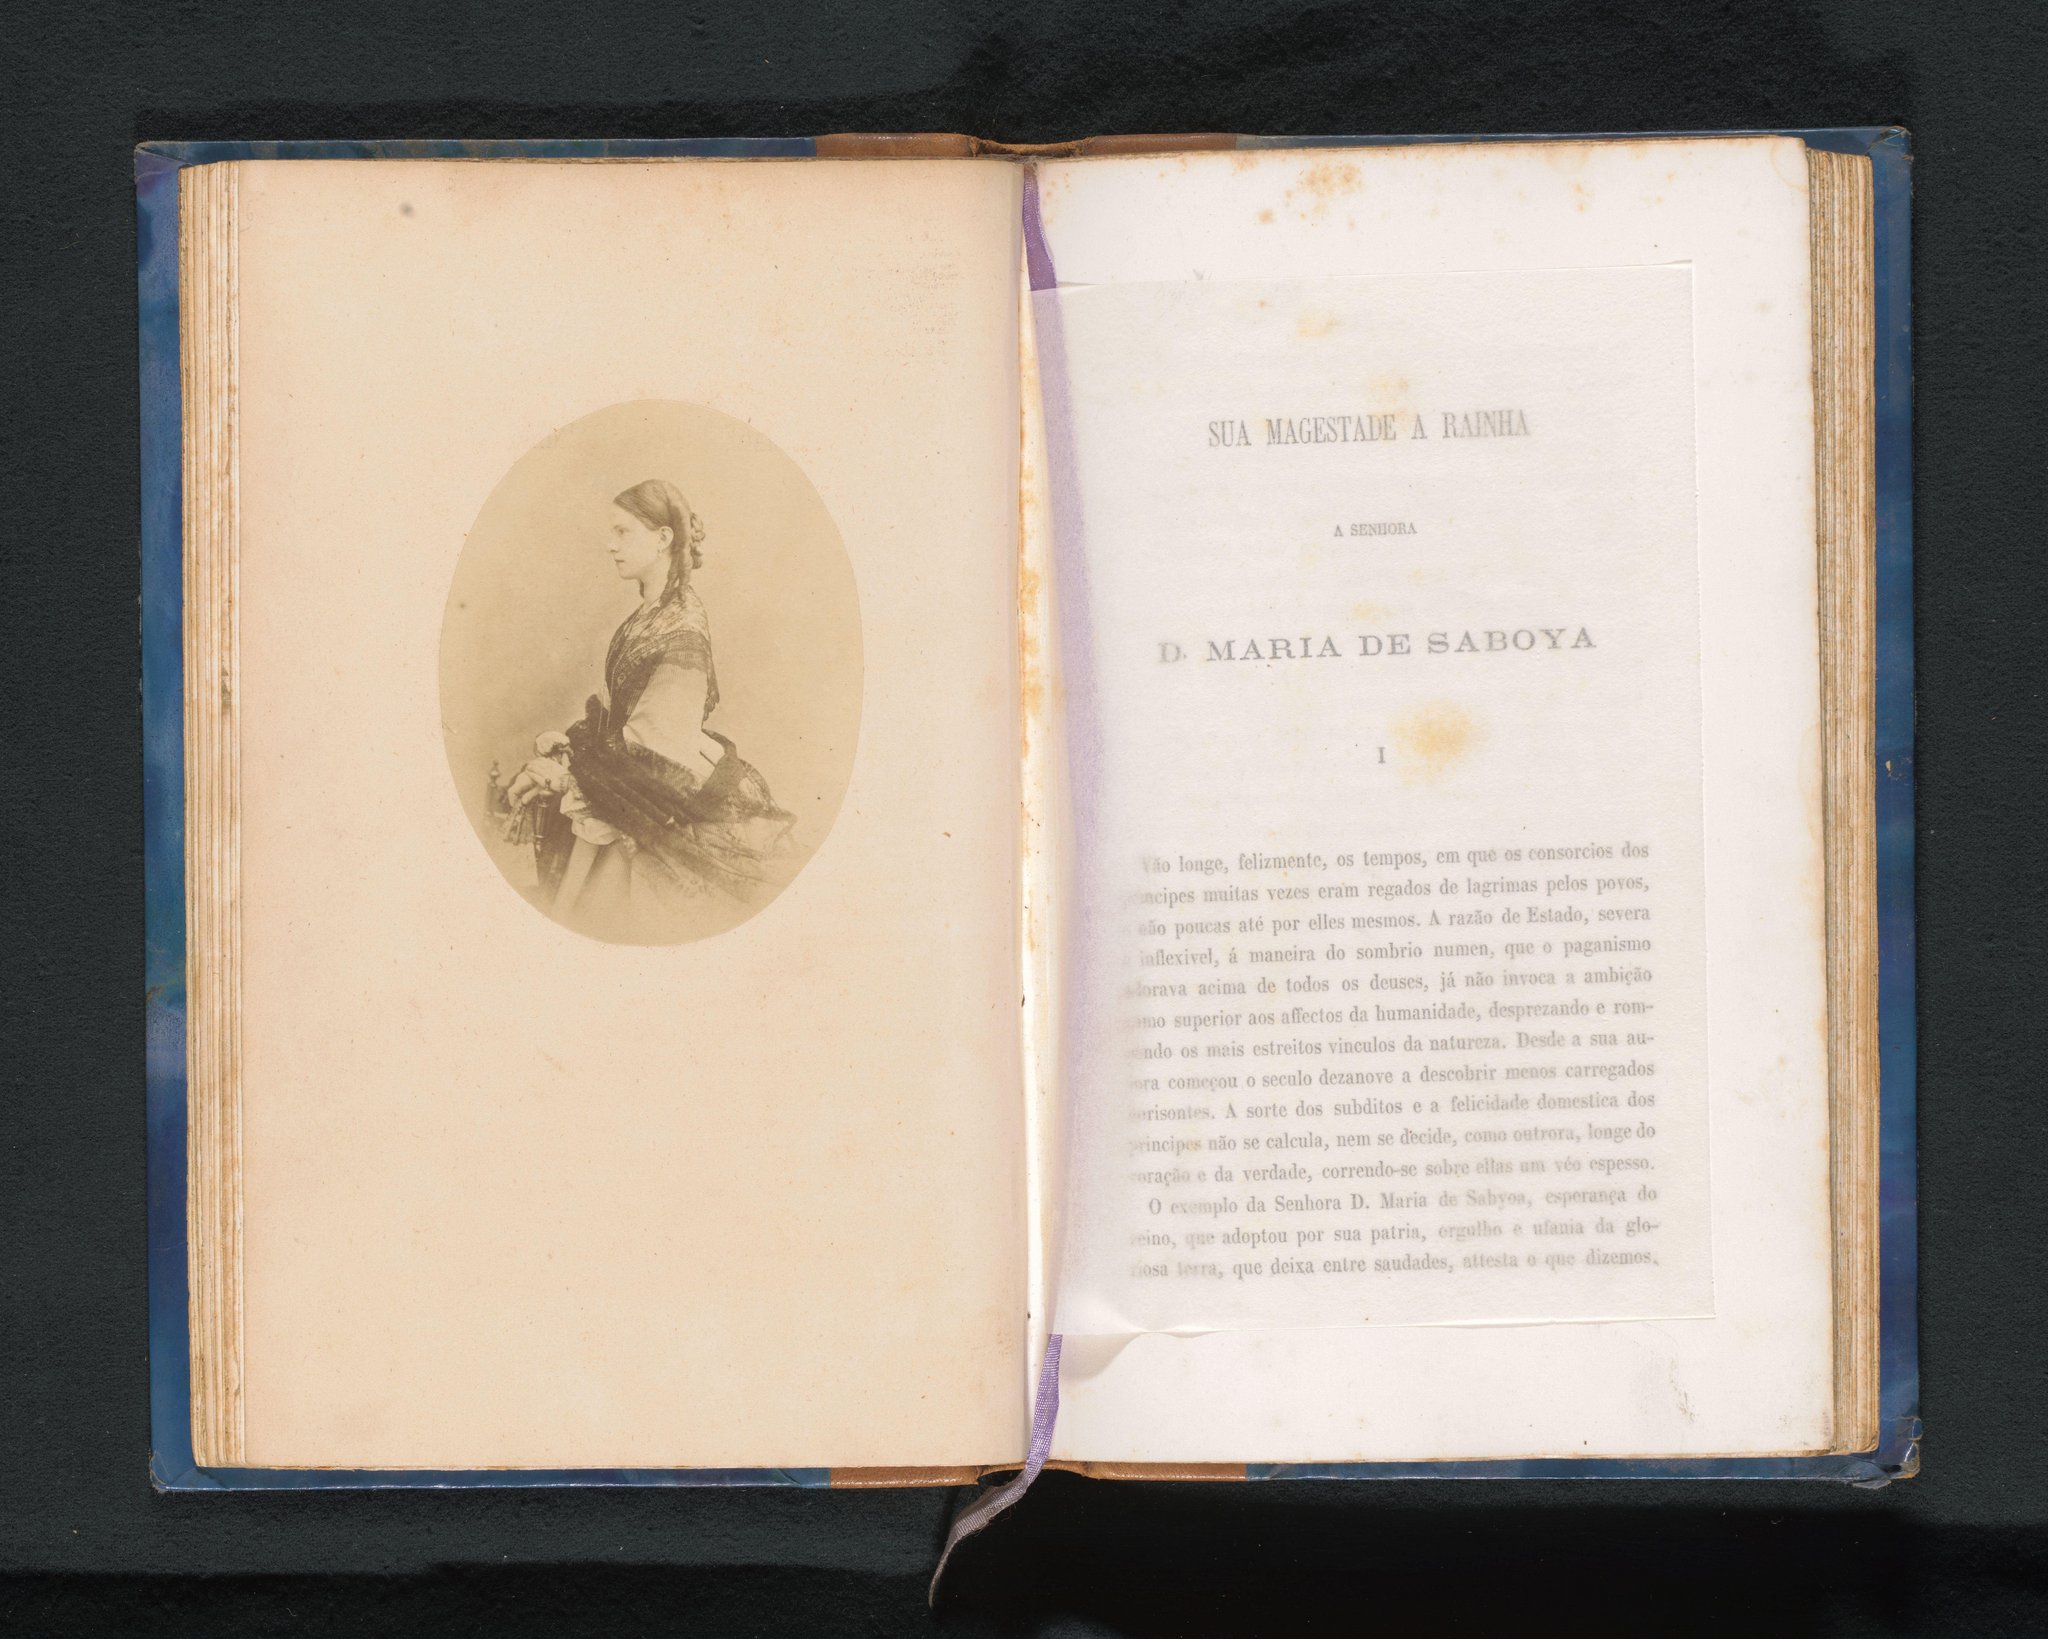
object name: page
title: Portret van koningin Maria Pia van Savoye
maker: Anonymous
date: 1861-1862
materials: photographic support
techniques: albumen print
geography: portugal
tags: ruler, sovereign - bb - female ruler